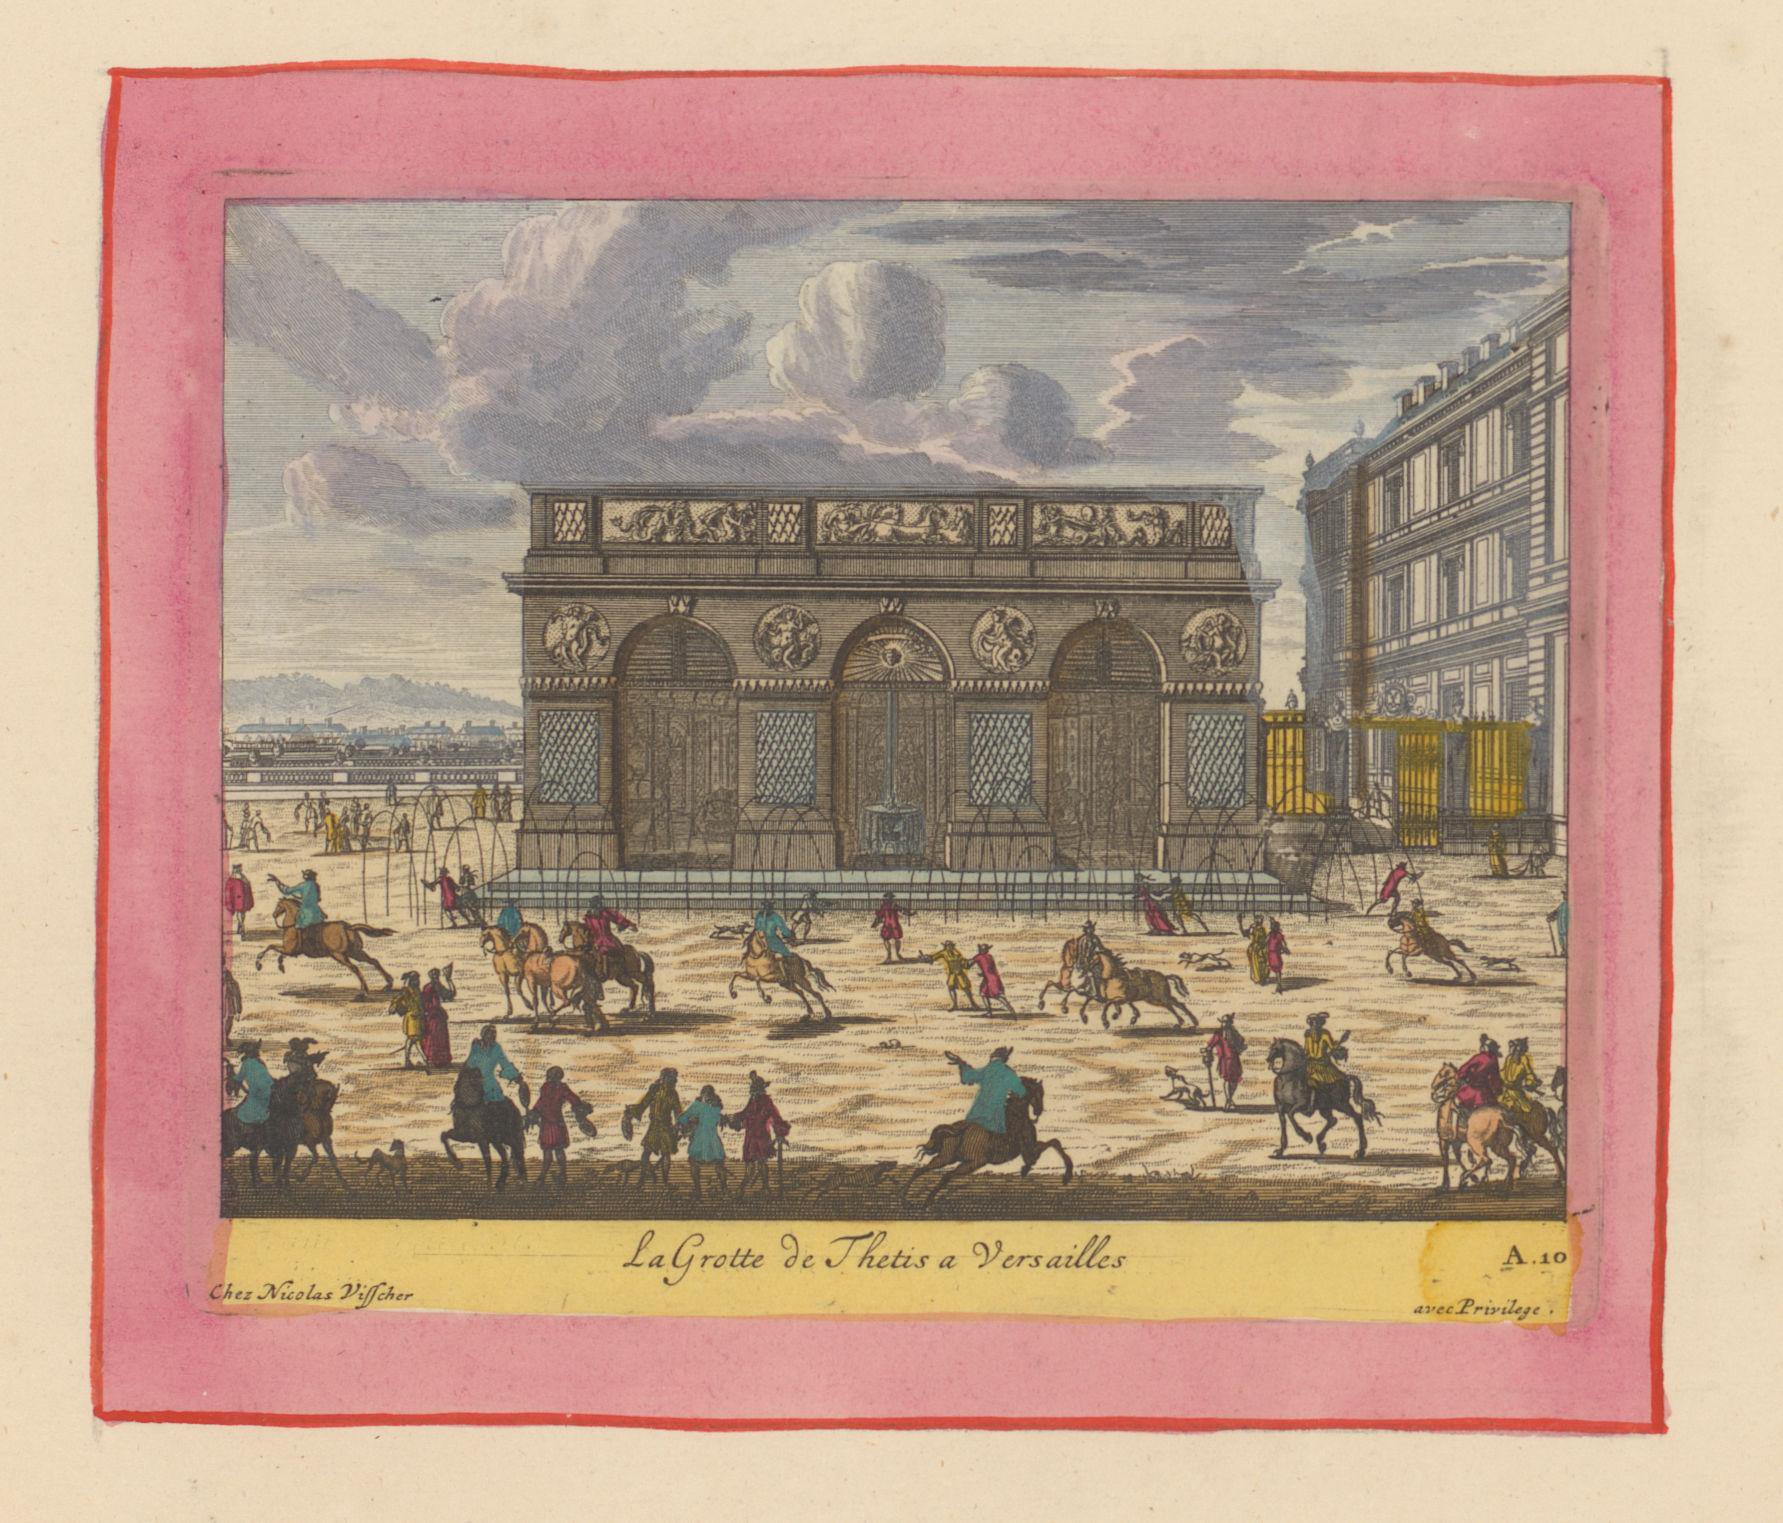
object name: album leaf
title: Grot van Thetis te Versailles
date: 1686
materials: paper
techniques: etching, hand coloring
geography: amsterdam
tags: french or architectonic garden; formal garden, artificial grotto in garden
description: De prent maakt deel uit van een serie bestaande uit 87 genummerde prenten (volgens Hollstein). De serie is opgedeeld in de delen A t/m F.